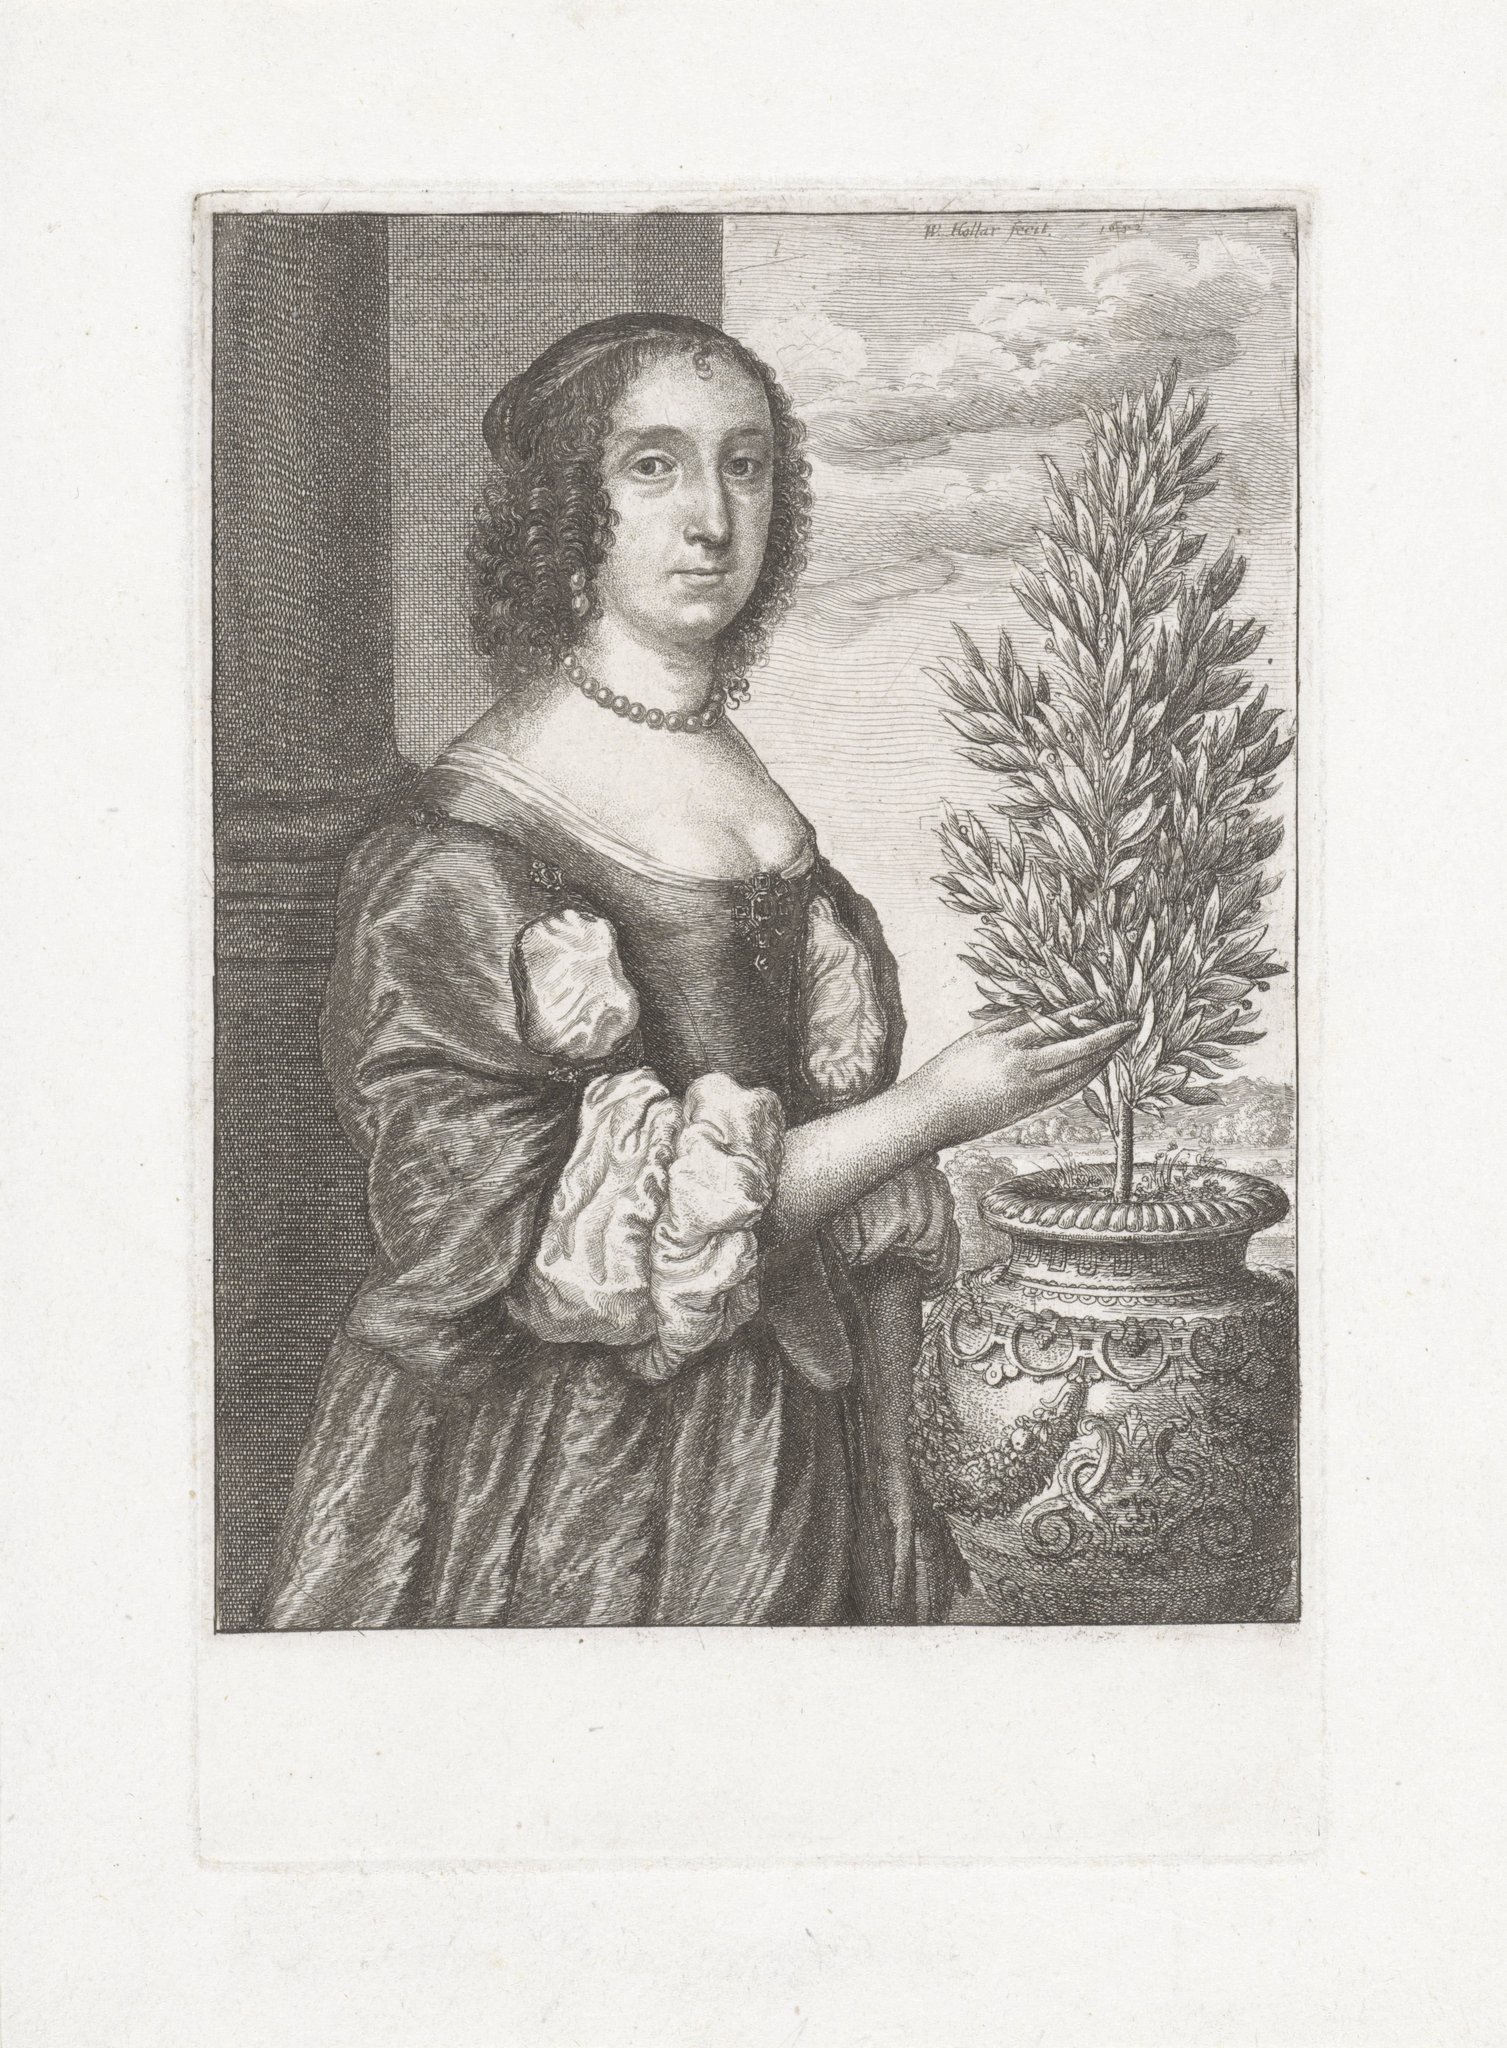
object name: print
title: Portret van een staande vrouw naast een laurierplant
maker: wenceslaus hollar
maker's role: draughtsman, print maker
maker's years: 1607-1677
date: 1652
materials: paper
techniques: etching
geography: antwerp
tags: anonymous historical person portrayed alone - bb - woman, trees: laurel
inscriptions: collector's mark: Lugt 2228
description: Mogelijk gaat het om Lady Sarah Garrard.